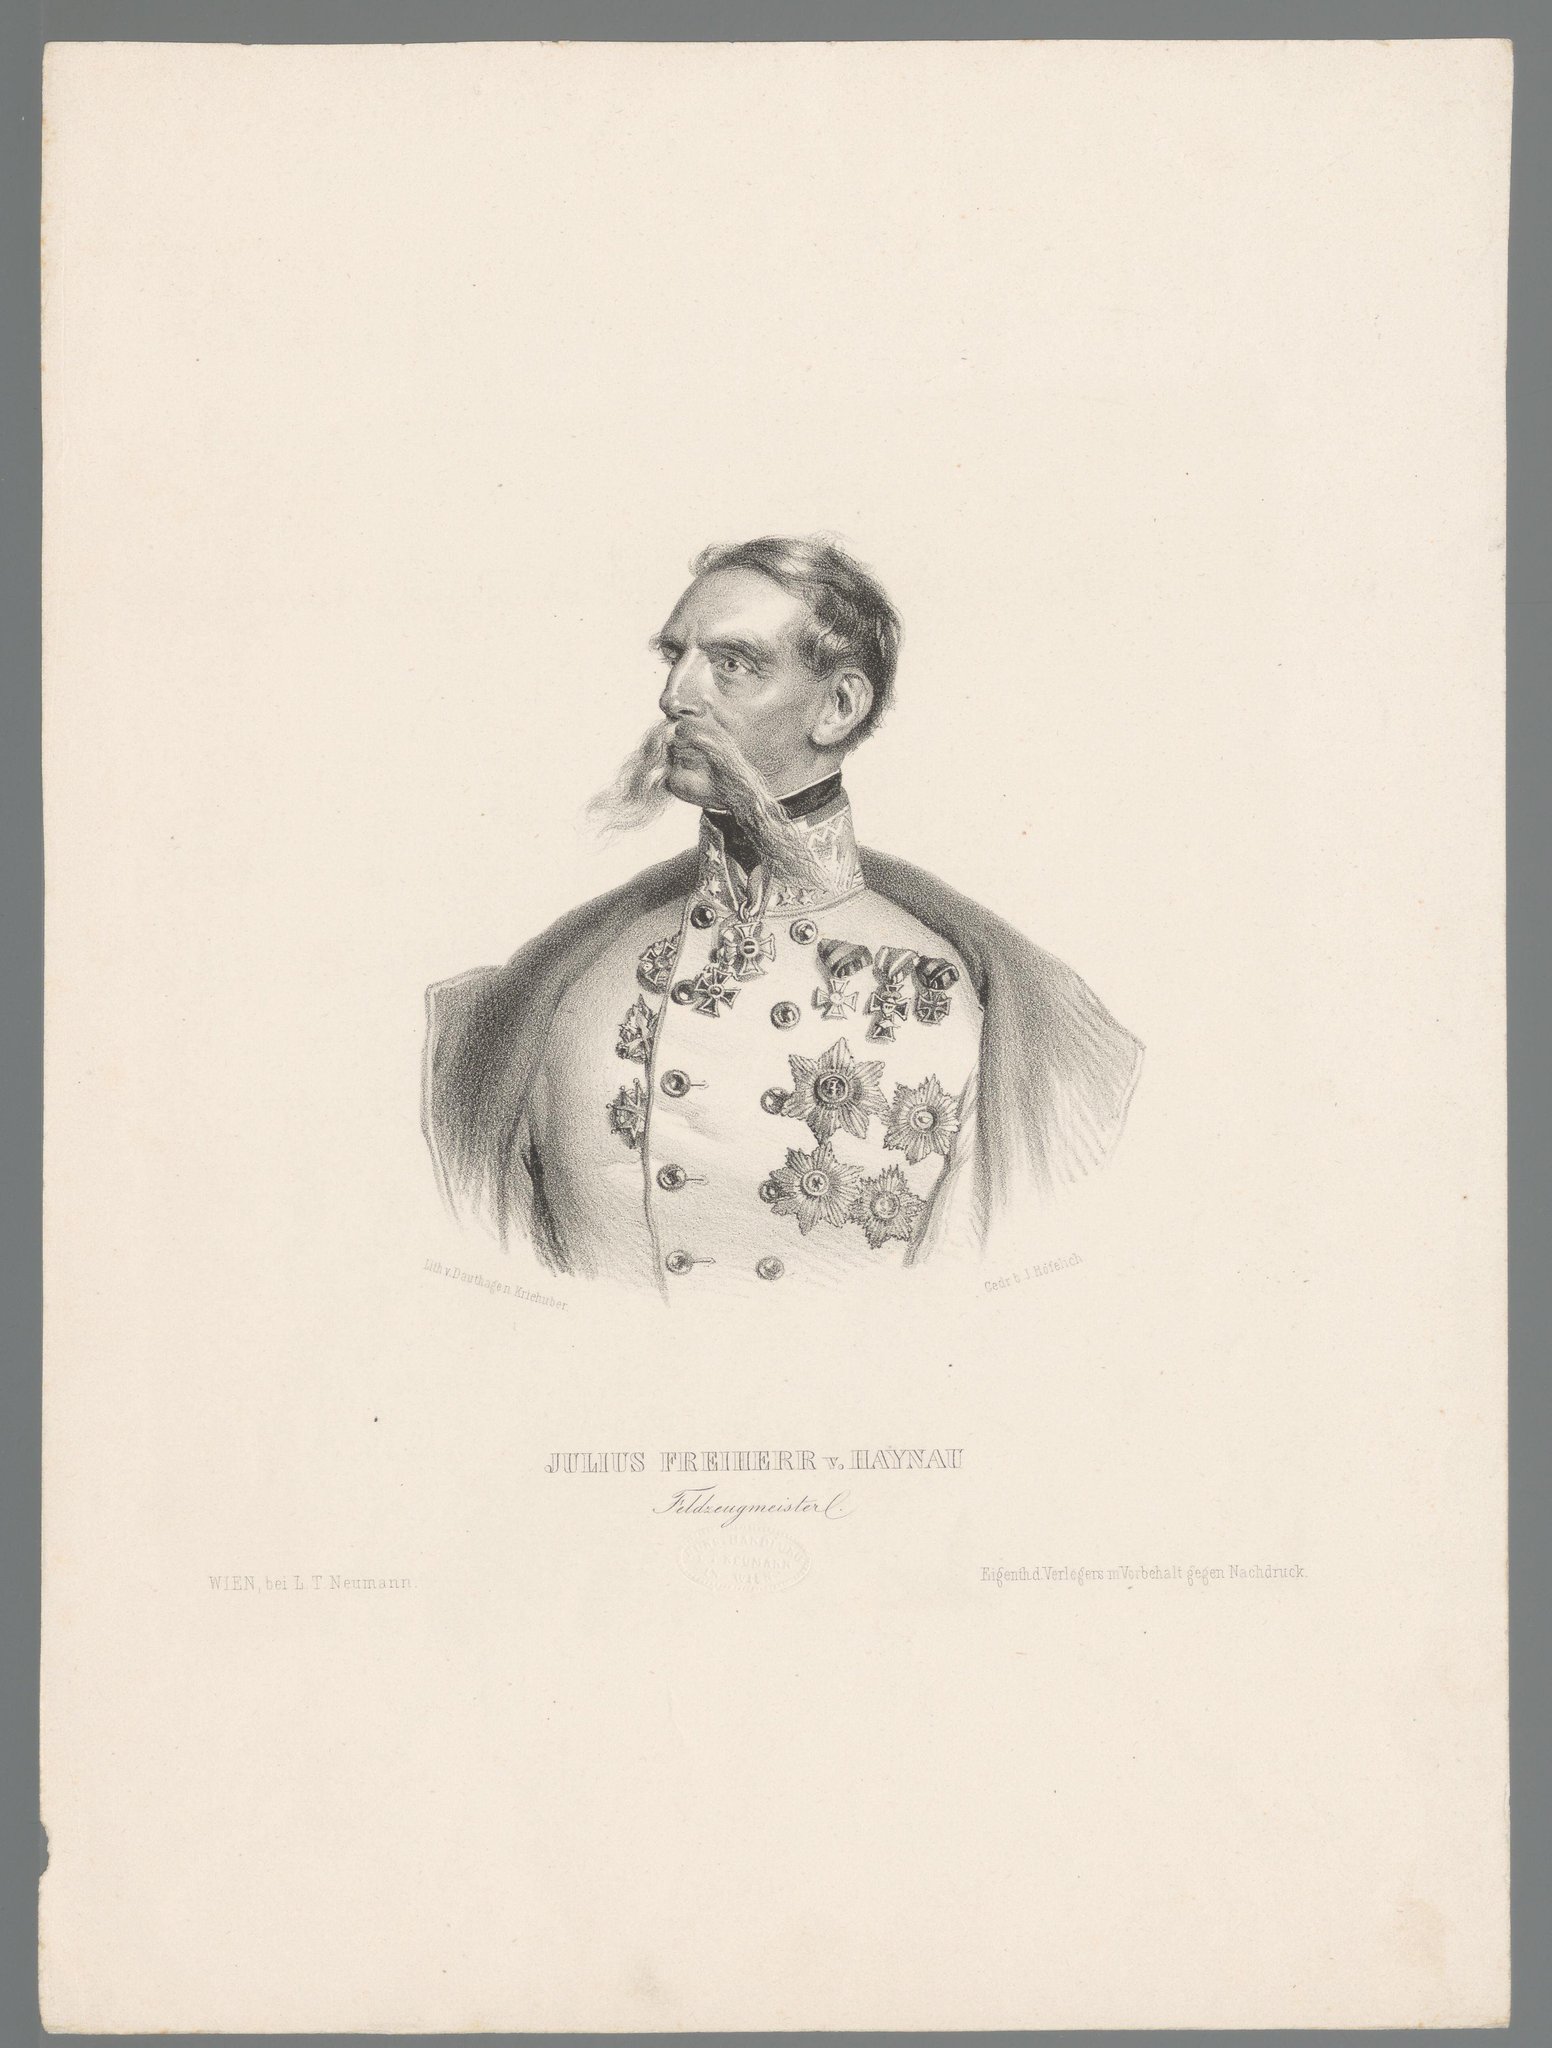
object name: print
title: Portret van Julius Jacob von Haynau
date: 1835-1849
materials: paper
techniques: lithograph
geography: vienna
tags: julius jacob von haynau, commander-in-chief, general, marshal, historical persons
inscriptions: check stamp: ‘Kunsthandlung L.T. Neumann im Wien’, collector's mark: Lugt 2228